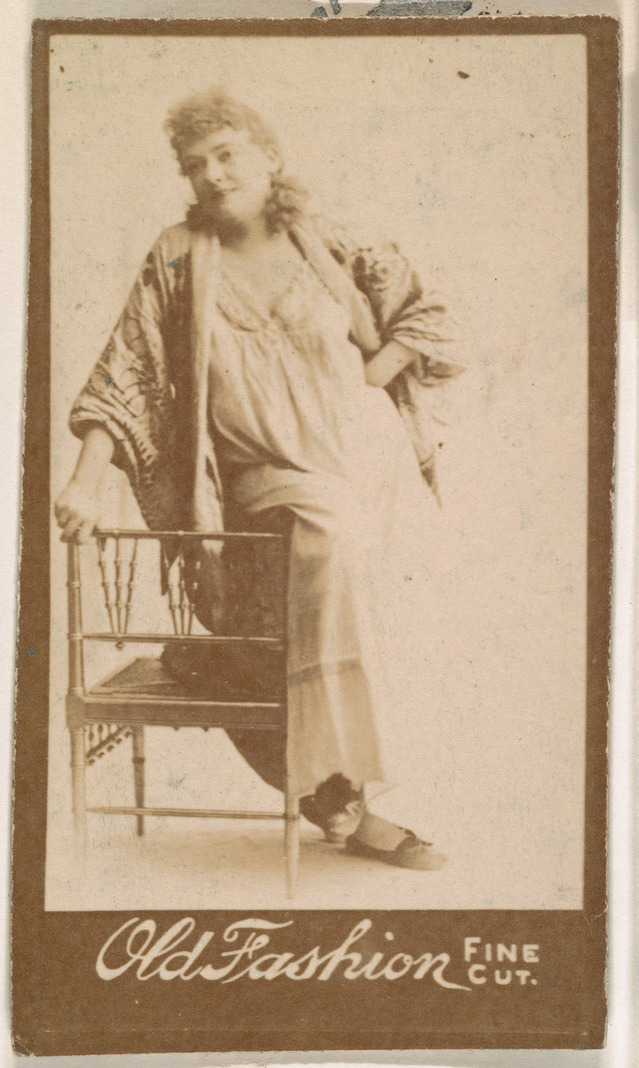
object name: photograph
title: Actress leaning against chair, from the Actresses series (N664) promoting Old Fashion Fine Cut Tobacco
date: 1888-1890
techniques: albumen silver print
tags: portraits,women,actresses